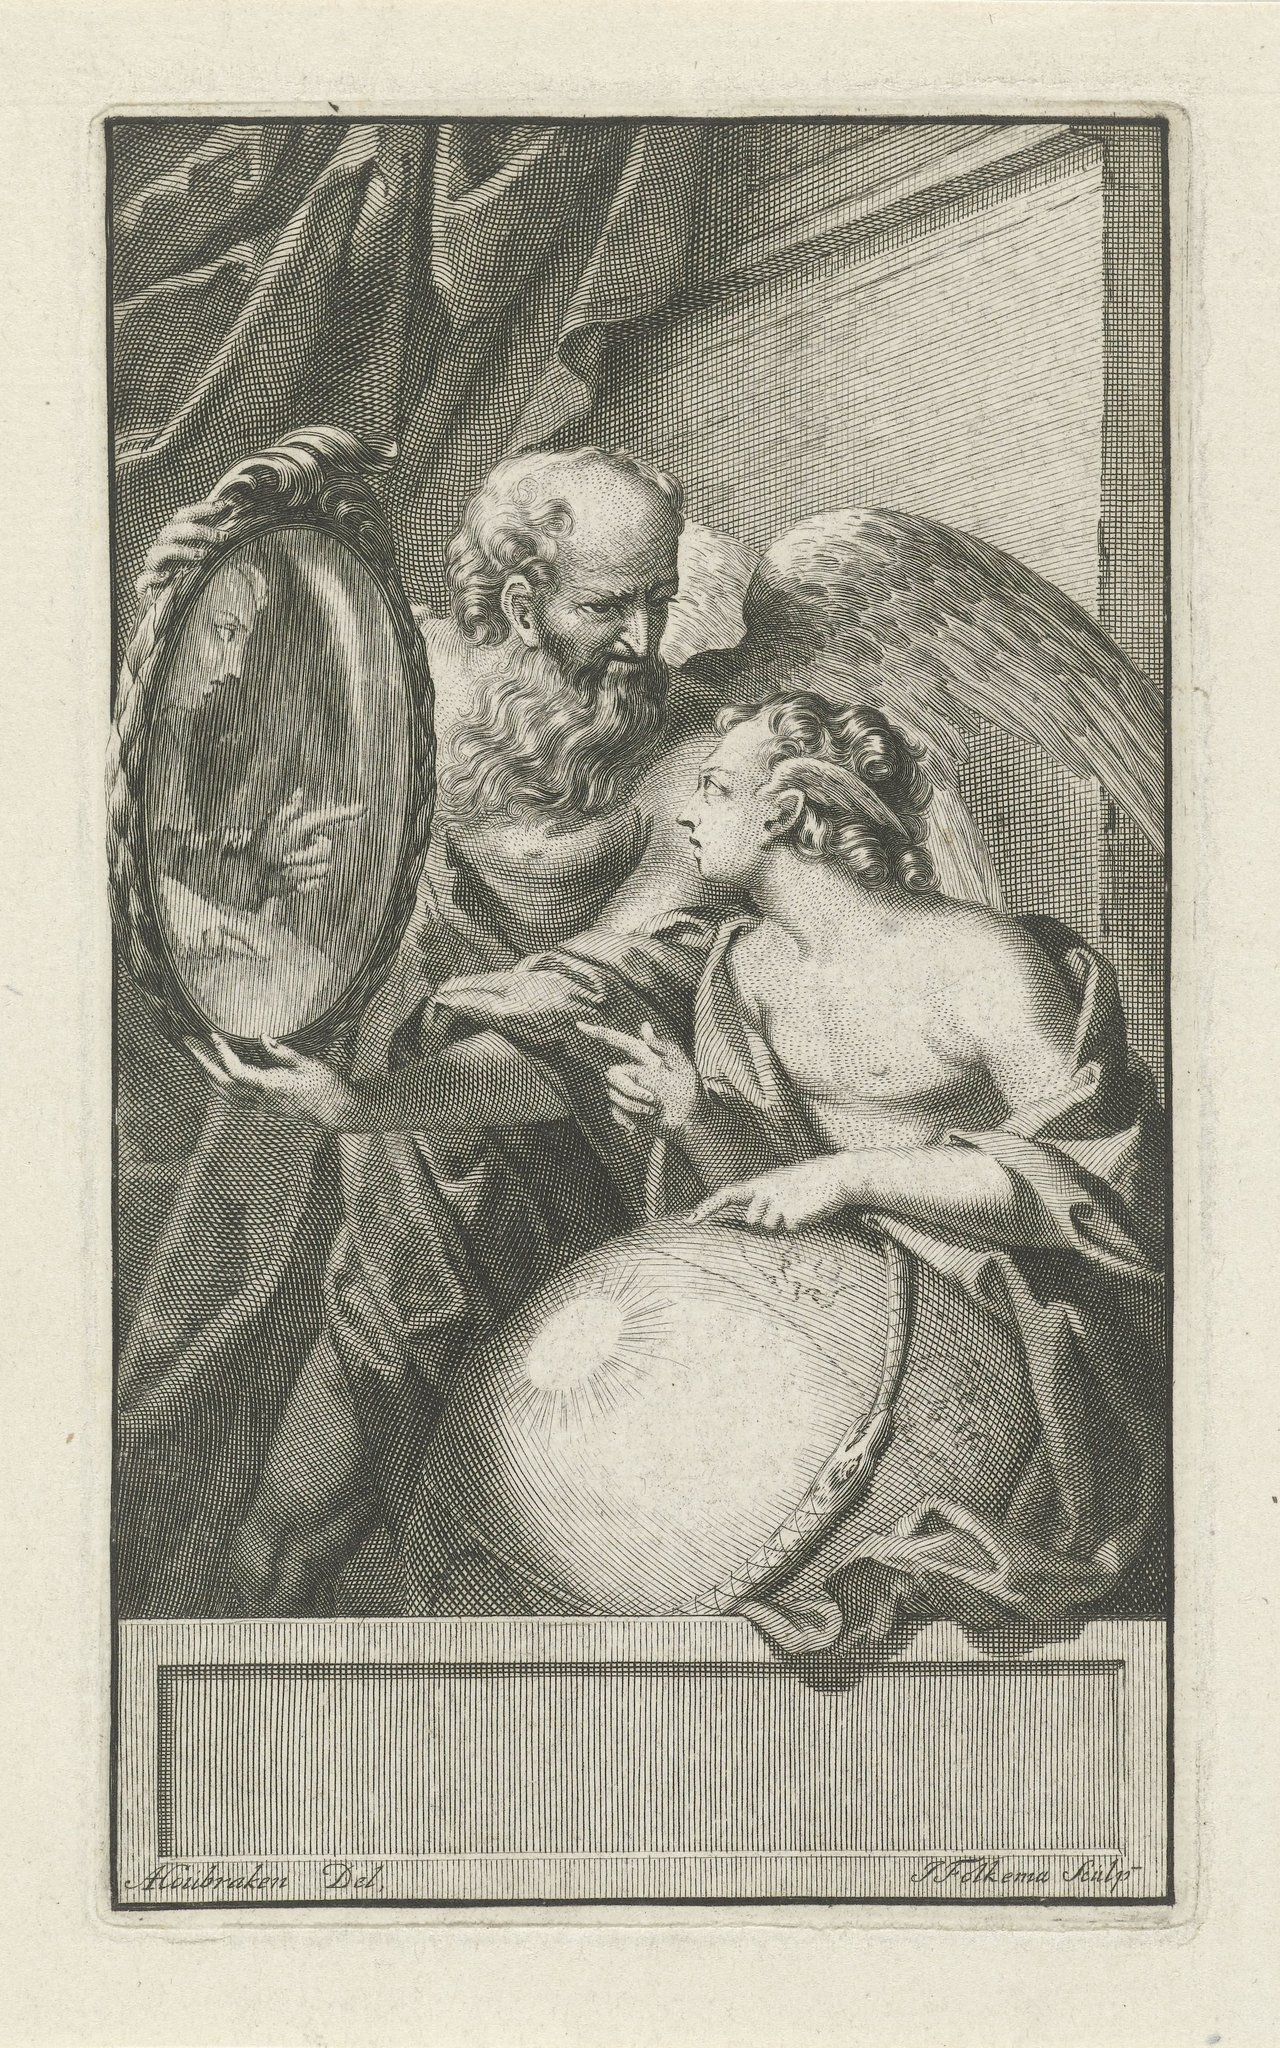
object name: print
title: Vader Tijd met spiegel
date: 1702-1767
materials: paper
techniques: etching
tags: allegorical representations of the effects of time, father time, man with wings and scythe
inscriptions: collector's mark: Lugt 240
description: Vader Tijd houdt een spiegel, symbool van de naakte waarheid, op voor een allegorische figuur die naast hem een globe bestudeert. Het hoofd van deze figuur is getooid met vleugeltjes waarmee zijn gevleugelde gedachten worden aangeduid. De globe wordt omringd door een slang die zich in zijn eigen staart bijt, symbool van eeuwigheid.